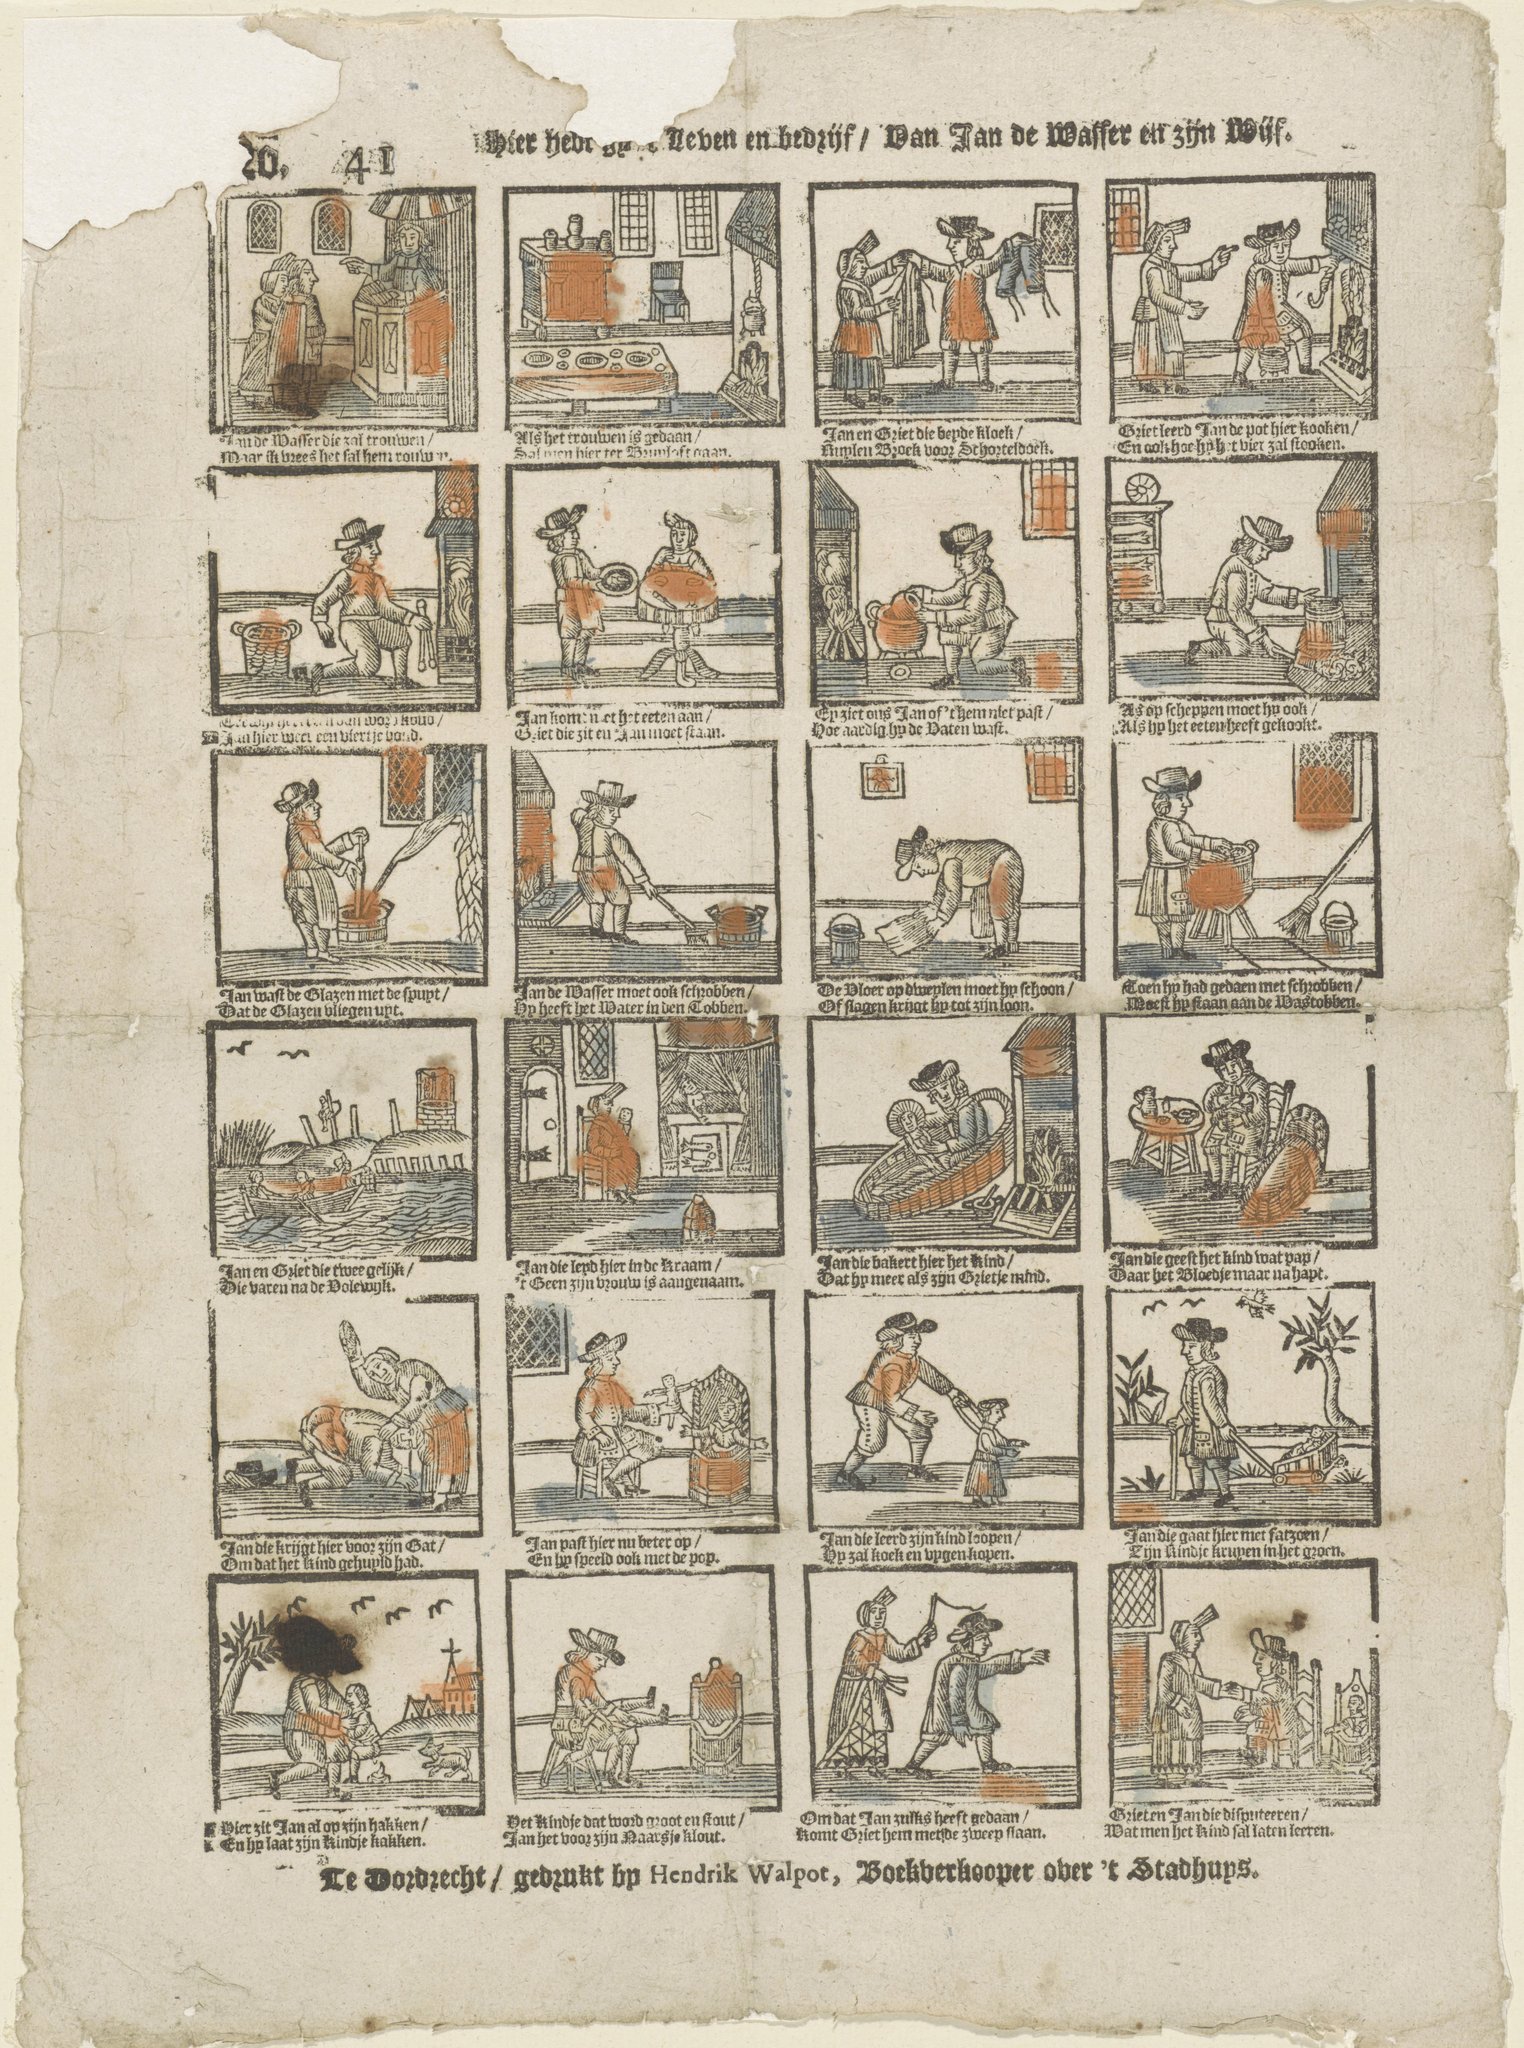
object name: print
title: Hier hebt gy 't leven en bedrijf / Van Jan de Wasser en zijn wijf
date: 1728-1759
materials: paper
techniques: colour, letterpress printing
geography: dordrecht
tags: battle for dominance in marriage ('who wears the breeches'), pulpit, ambo, chancel, cradle, crib, whip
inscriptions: collector's mark: Lugt 2228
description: Blad met 24 voorstellingen uit het leven van Jan de Wasser, een man die van zijn vrouw Griet, die de broek aan heeft, al het huishoudelijk werk moet doen. Onder elke voorstelling een tweeregelig vers. Genummerd linksboven: No. 41.